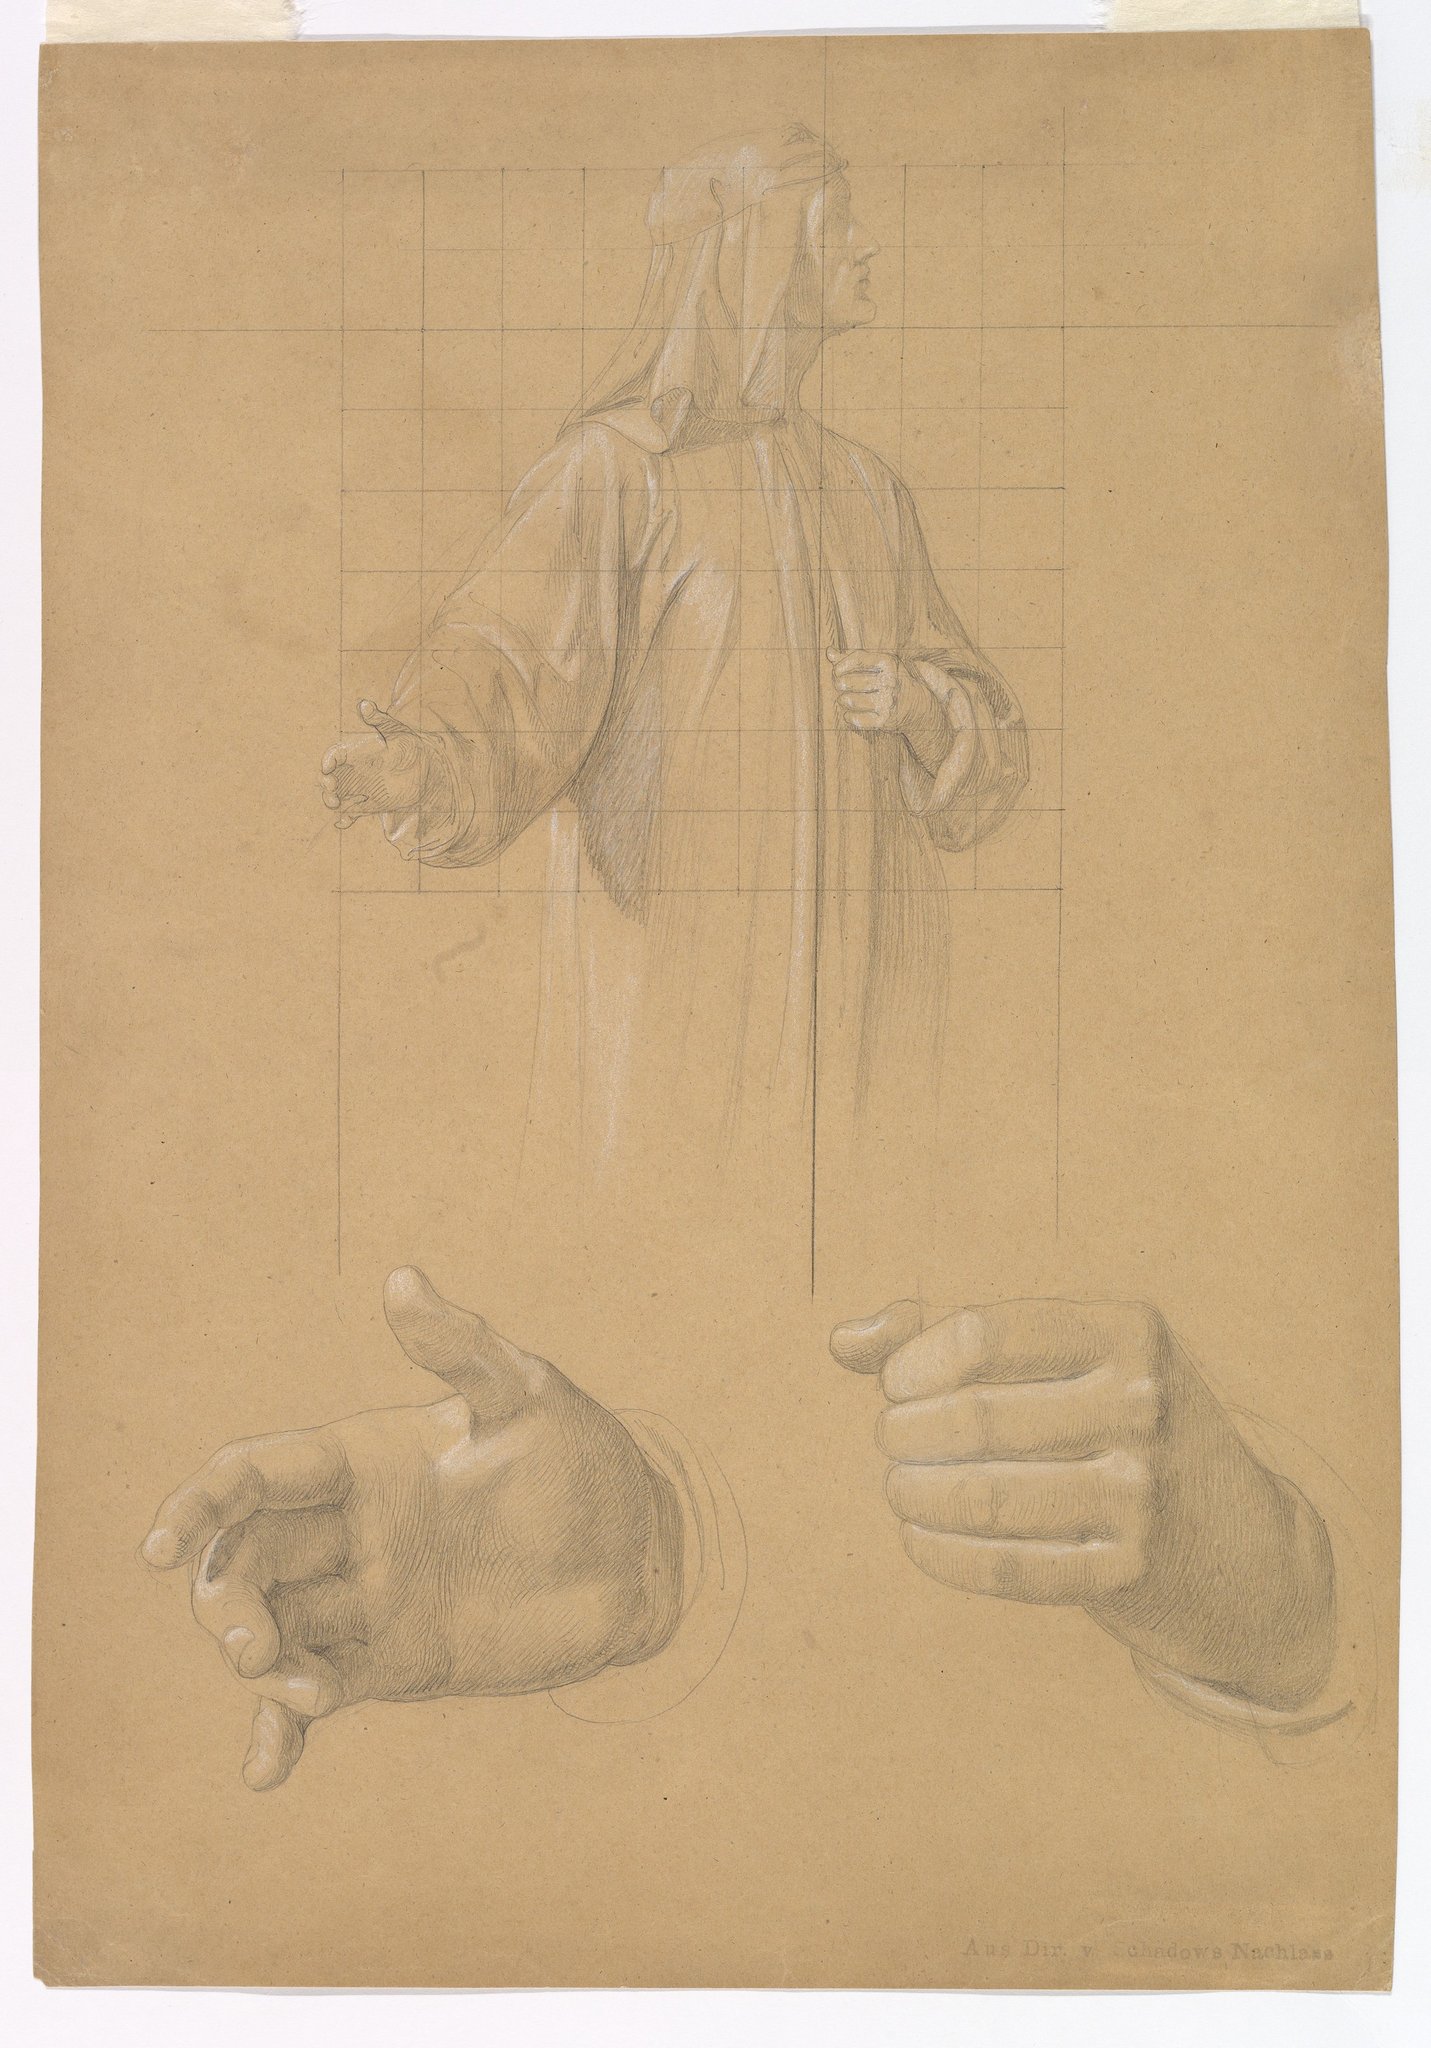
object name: drawing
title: Study of a Standing Man with Headcloth and Two Studies of his Hands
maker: wilhelm schadow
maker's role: artist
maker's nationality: german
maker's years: 1788-1862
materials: chalk, graphite, paper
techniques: heightening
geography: germany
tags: hands,men